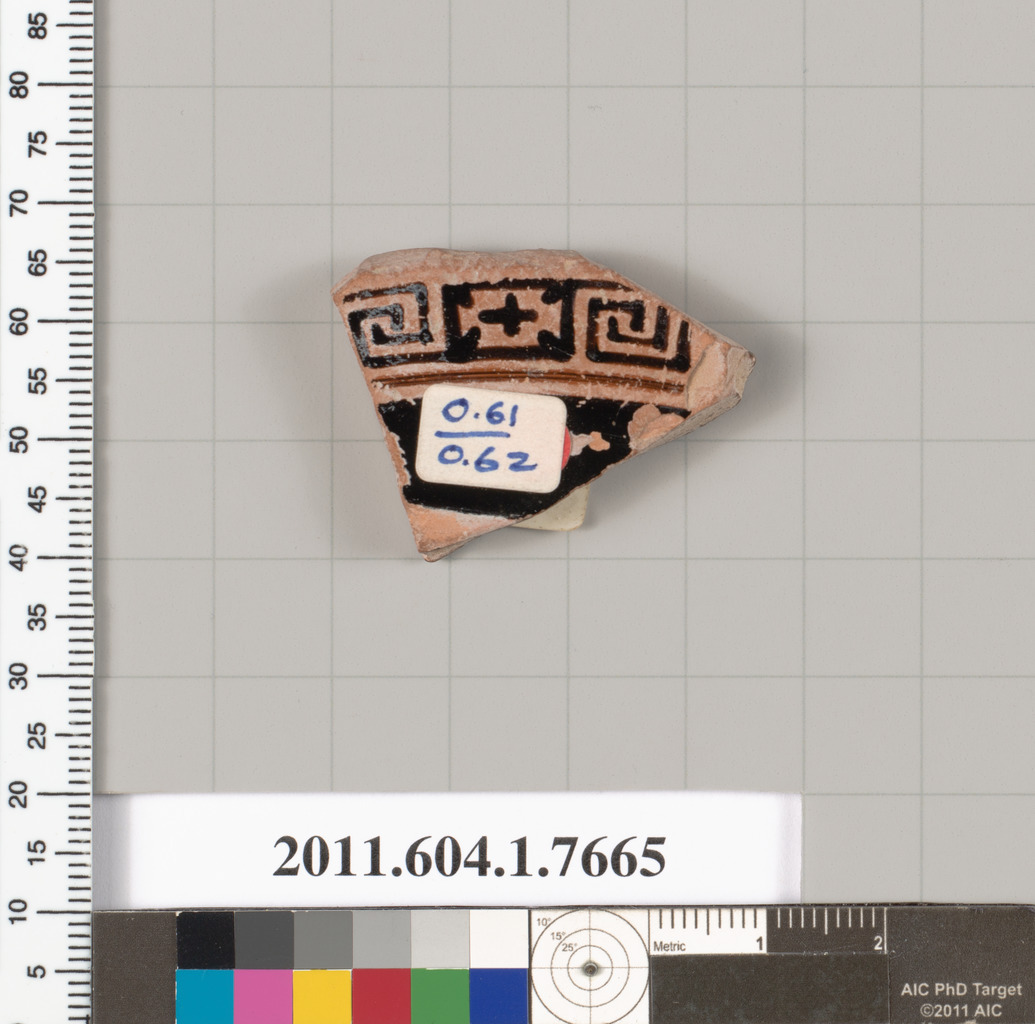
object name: kylix fragment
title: Terracotta fragment of a kylix (drinking cup)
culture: greek, attic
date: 460-450 BCE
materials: terracotta